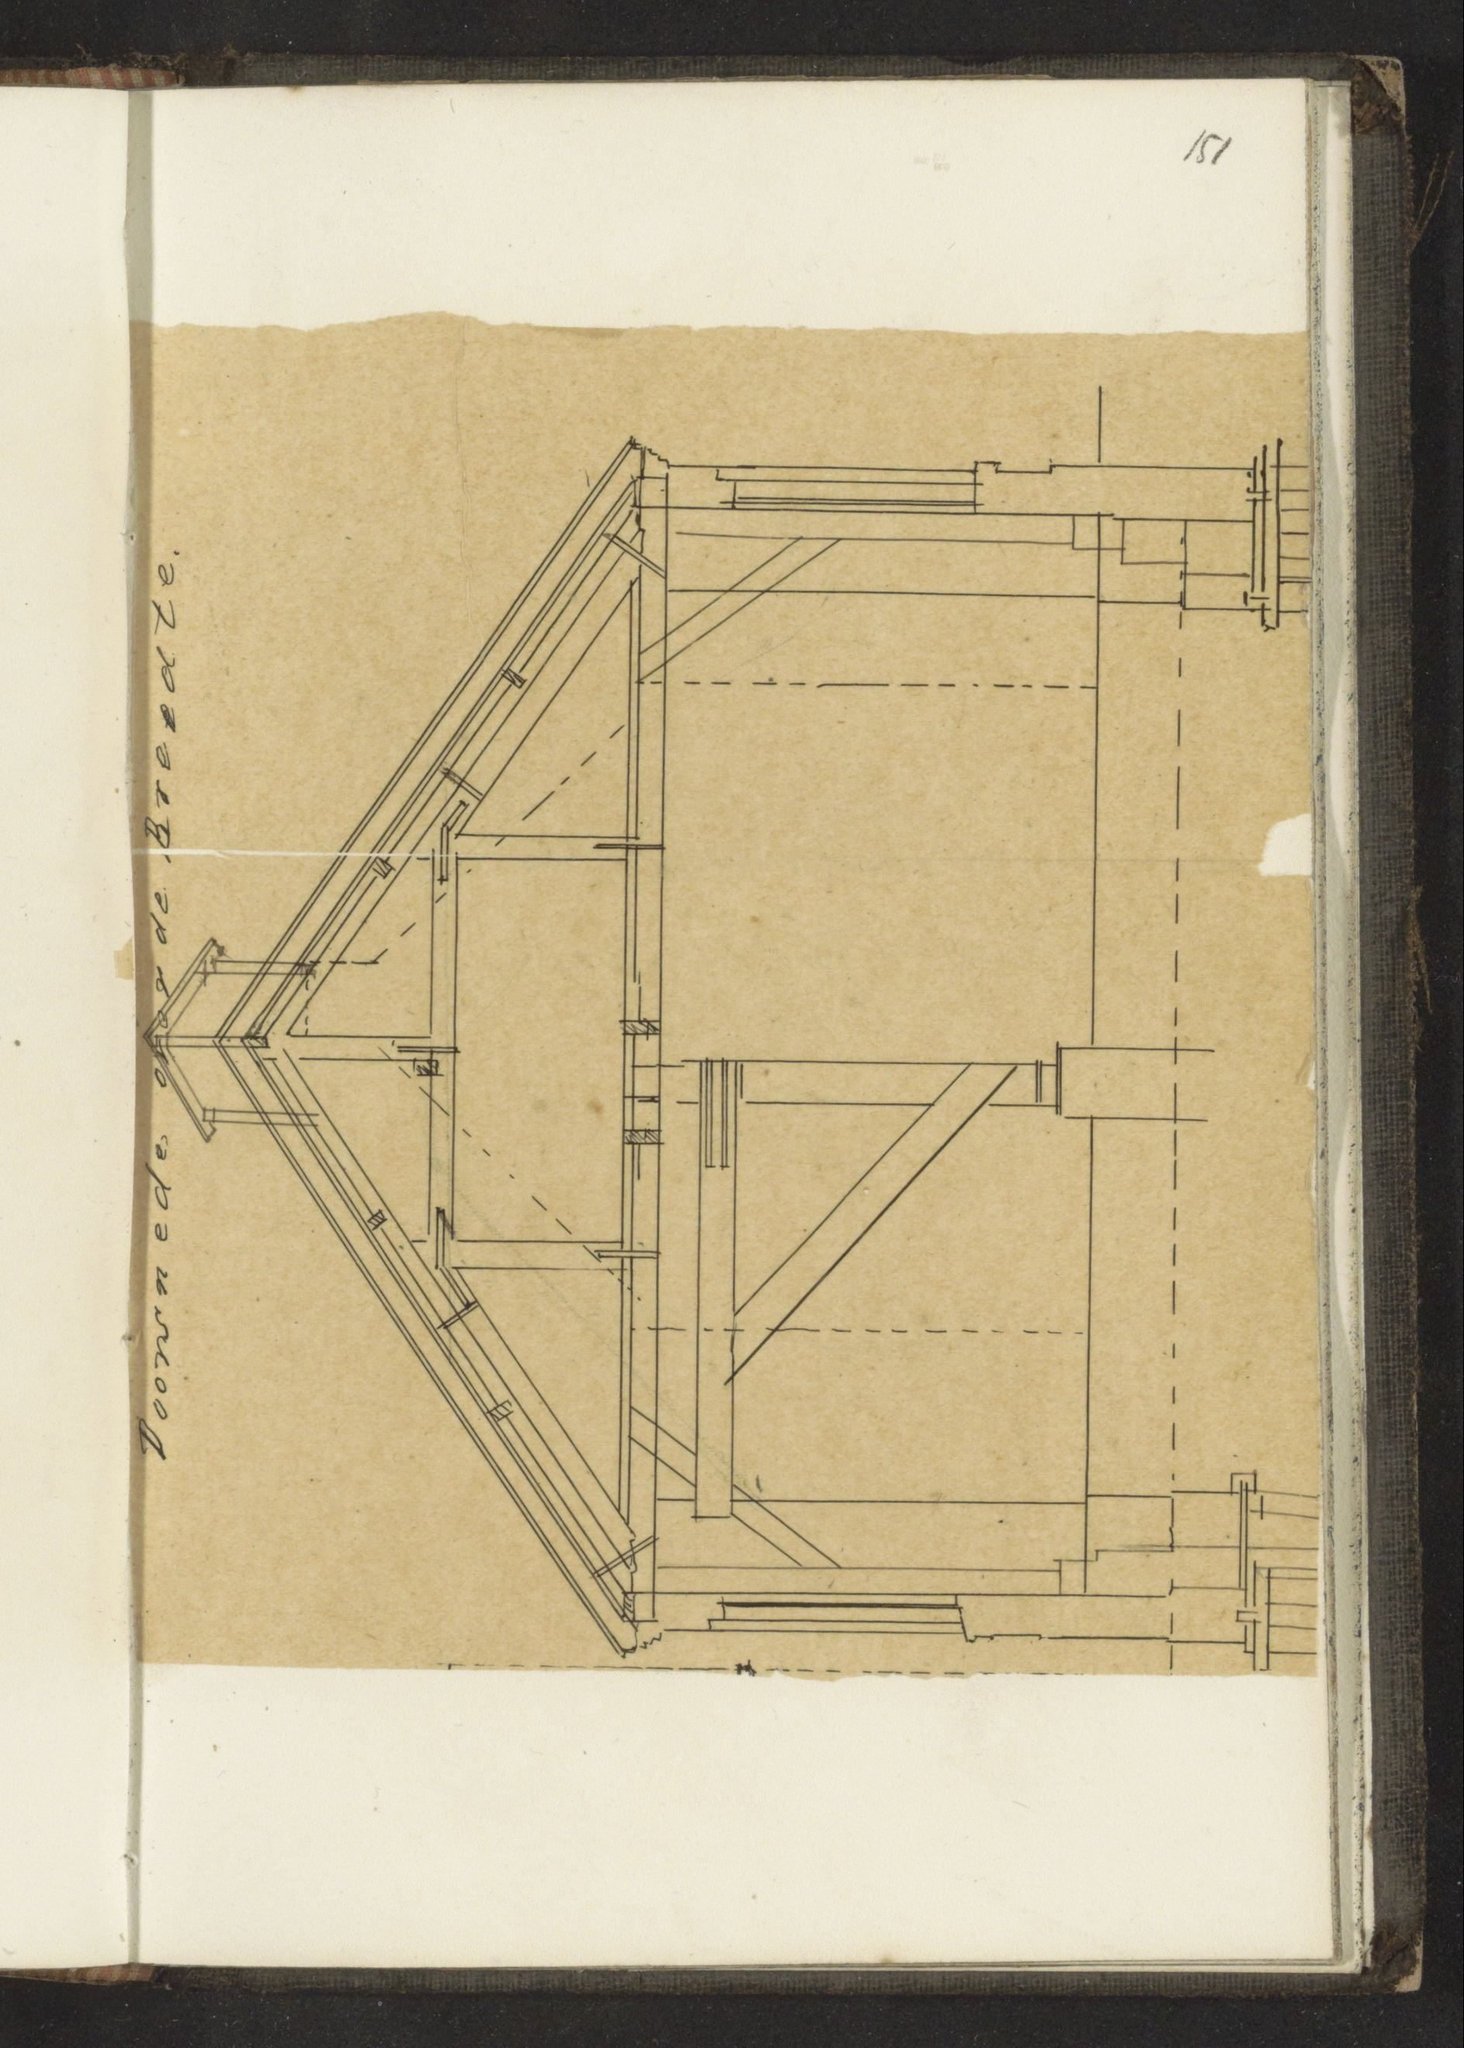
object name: sketchbook leaf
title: Doorsnede van een gebouw over de breedte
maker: willem springer jr.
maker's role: draughtsman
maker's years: 1815-1907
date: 1864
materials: ink, paper, pencil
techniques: pen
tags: section ~ architectural design or model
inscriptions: annotation: ‘Doorsnede over de Breedte’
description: Pagina 151 uit een schetsboek met 164 pagina's.